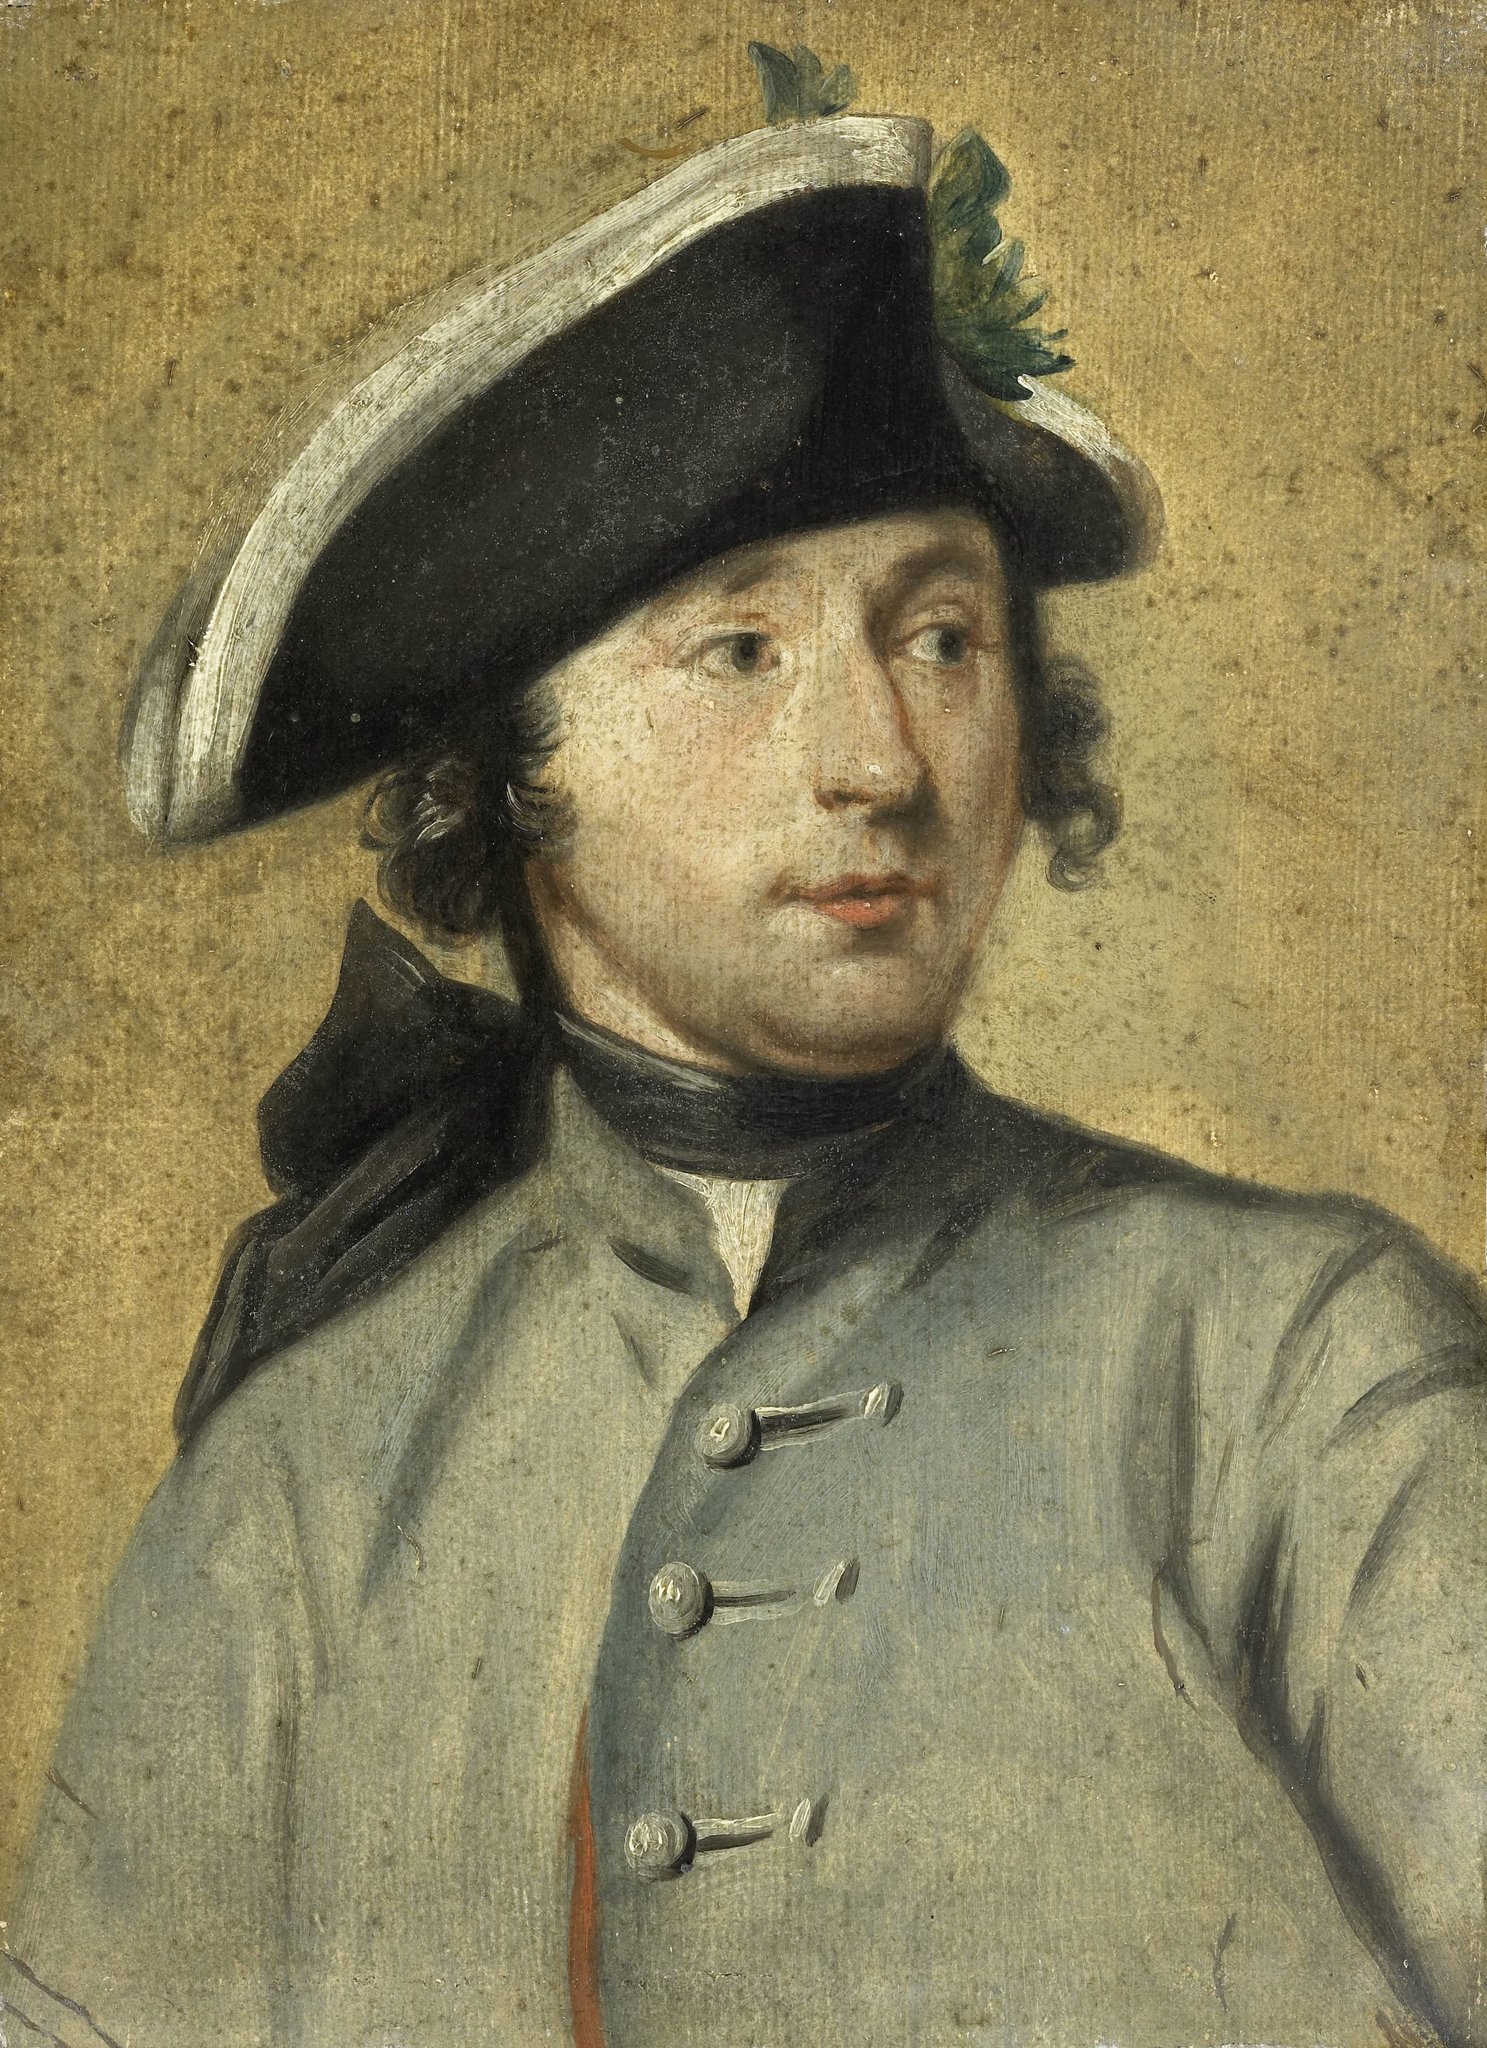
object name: painting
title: Portrait of Ludolf Backhuysen II, Painter and Dragoon, Grandson of the Marine Painter Ludolf Backhuysen I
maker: cornelis troost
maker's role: draughtsman, painter, print maker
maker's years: 1696-1750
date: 1735-1750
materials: oil, panel, paper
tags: amsterdam, rotterdam, painter, historical persons, portrait, self-portrait of artist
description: Portret van Ludolf Bakhuysen (II) (1717-82), schilder en militair, kleinzoon van de zeeschilder Ludolf Bakhuysen (I). Buste naar rechts.